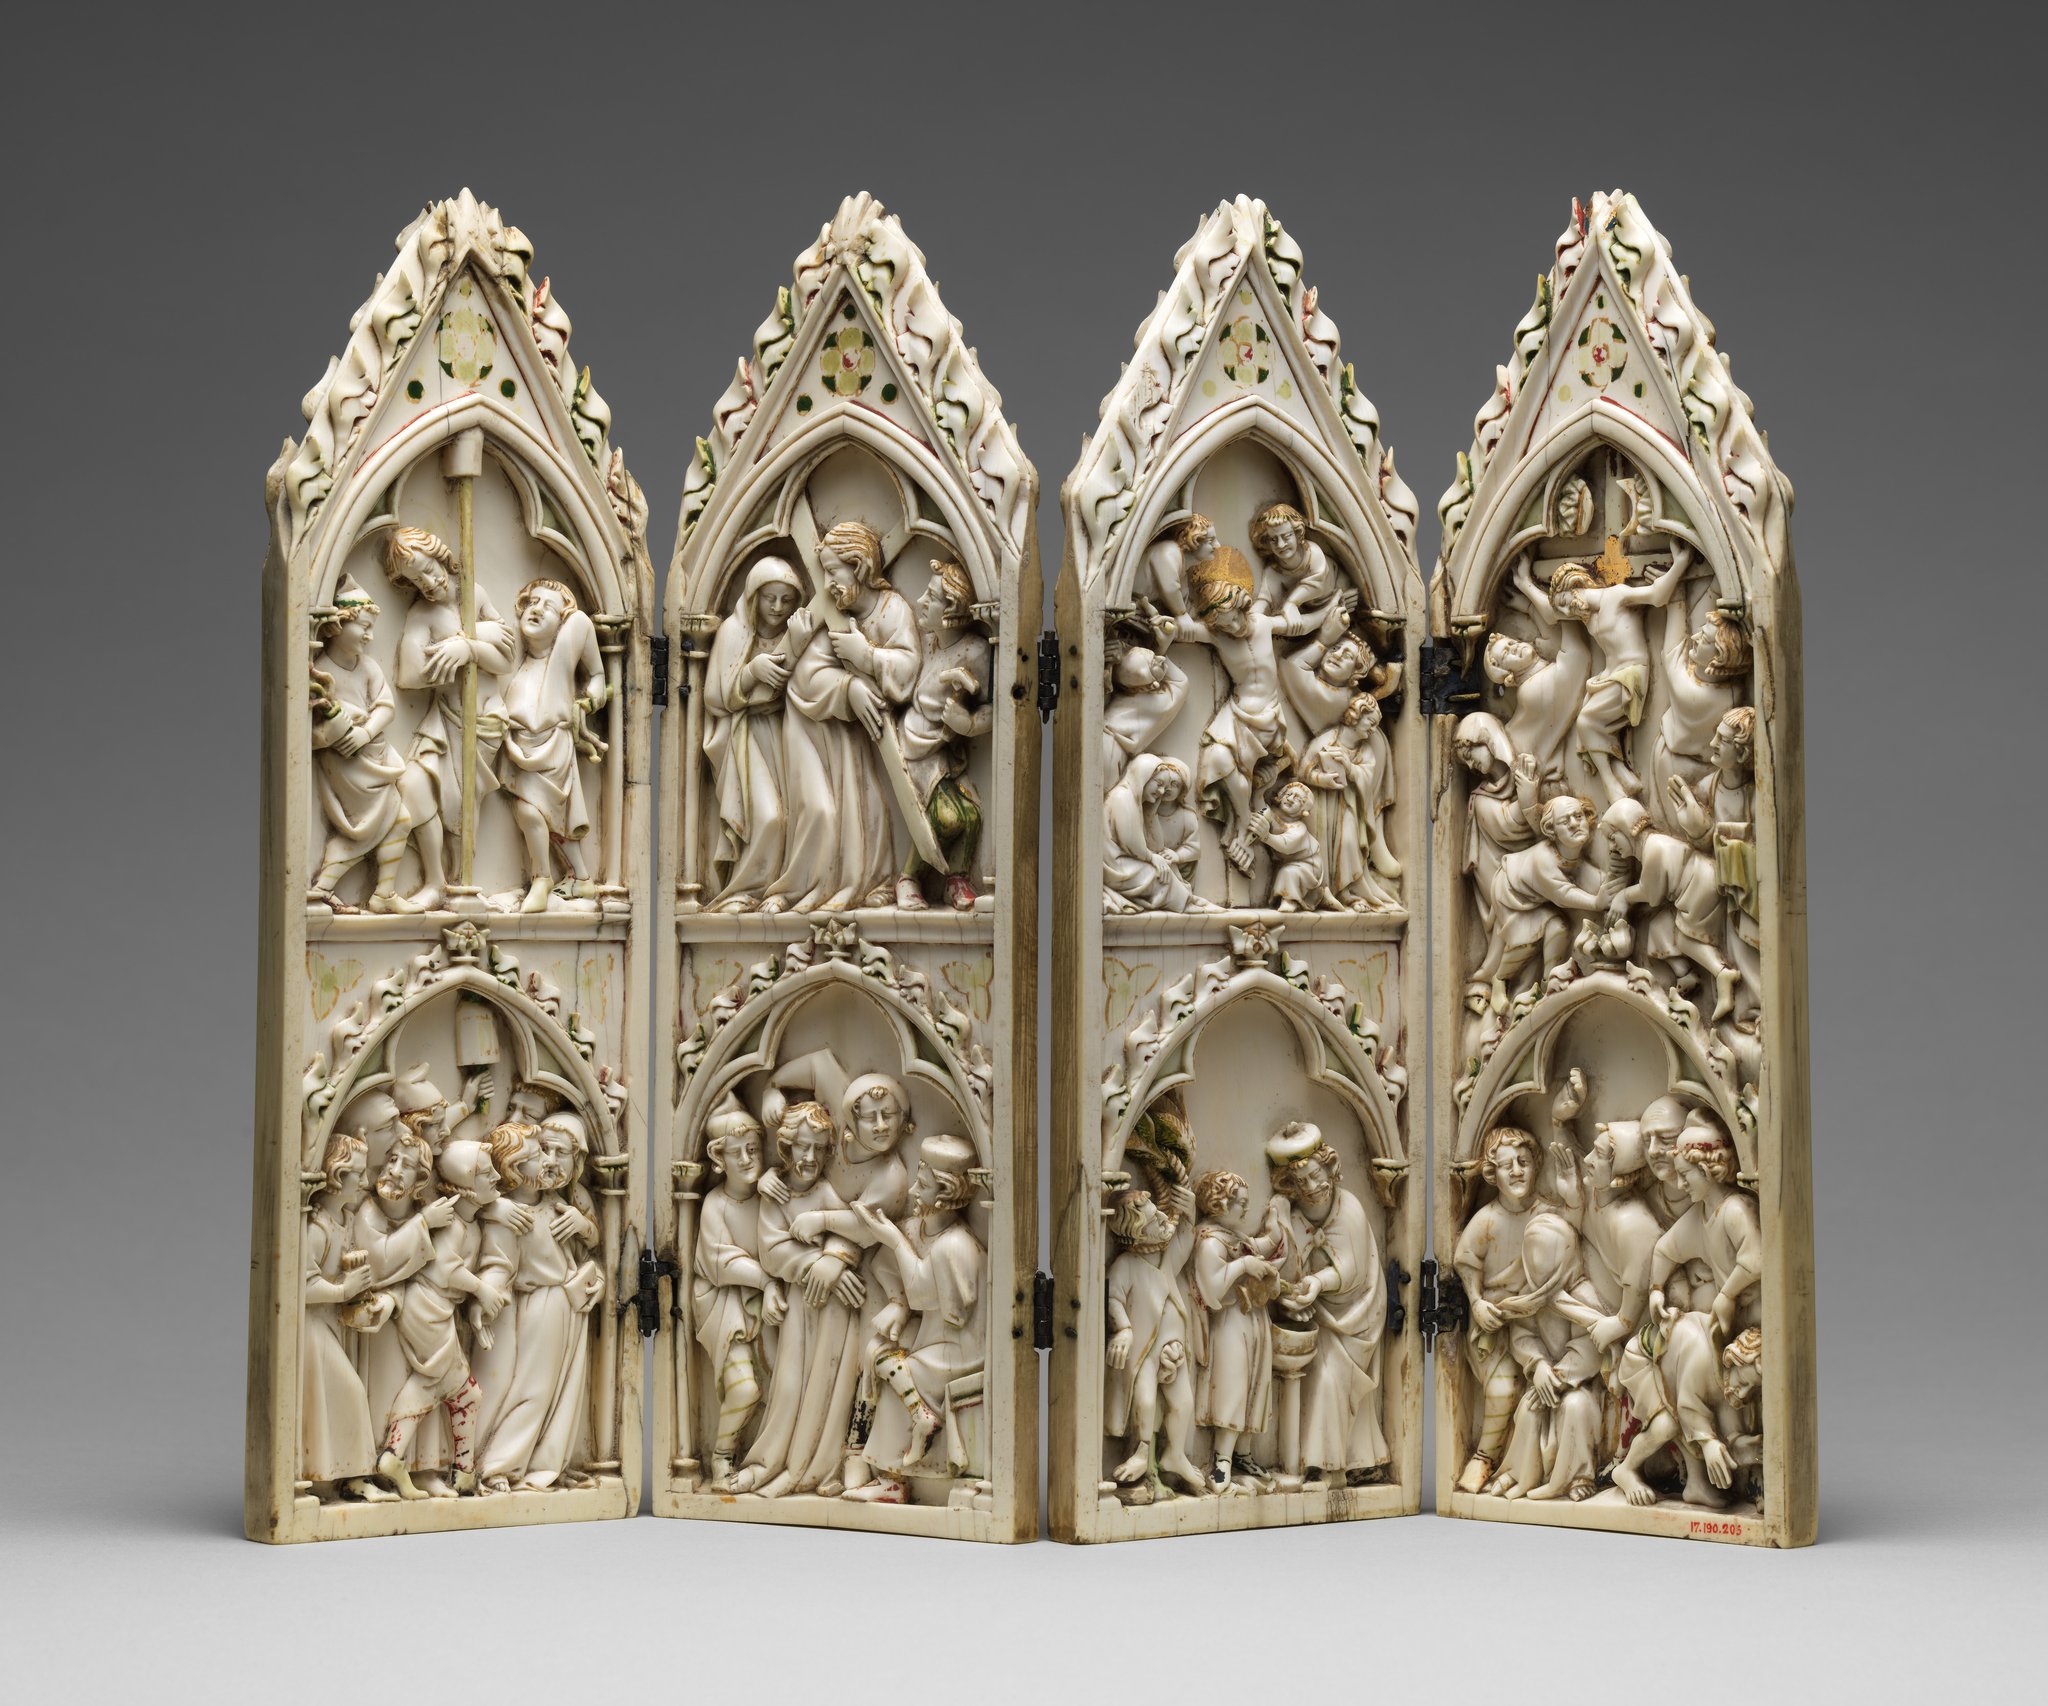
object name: polyptych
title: Folding Devotional Shrine with Scenes from Christ's Passion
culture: french or german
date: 1350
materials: ivory, metal, paint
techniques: gilding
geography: france or germany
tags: men,women,christ,bearing the cross,crucifixion,pilate